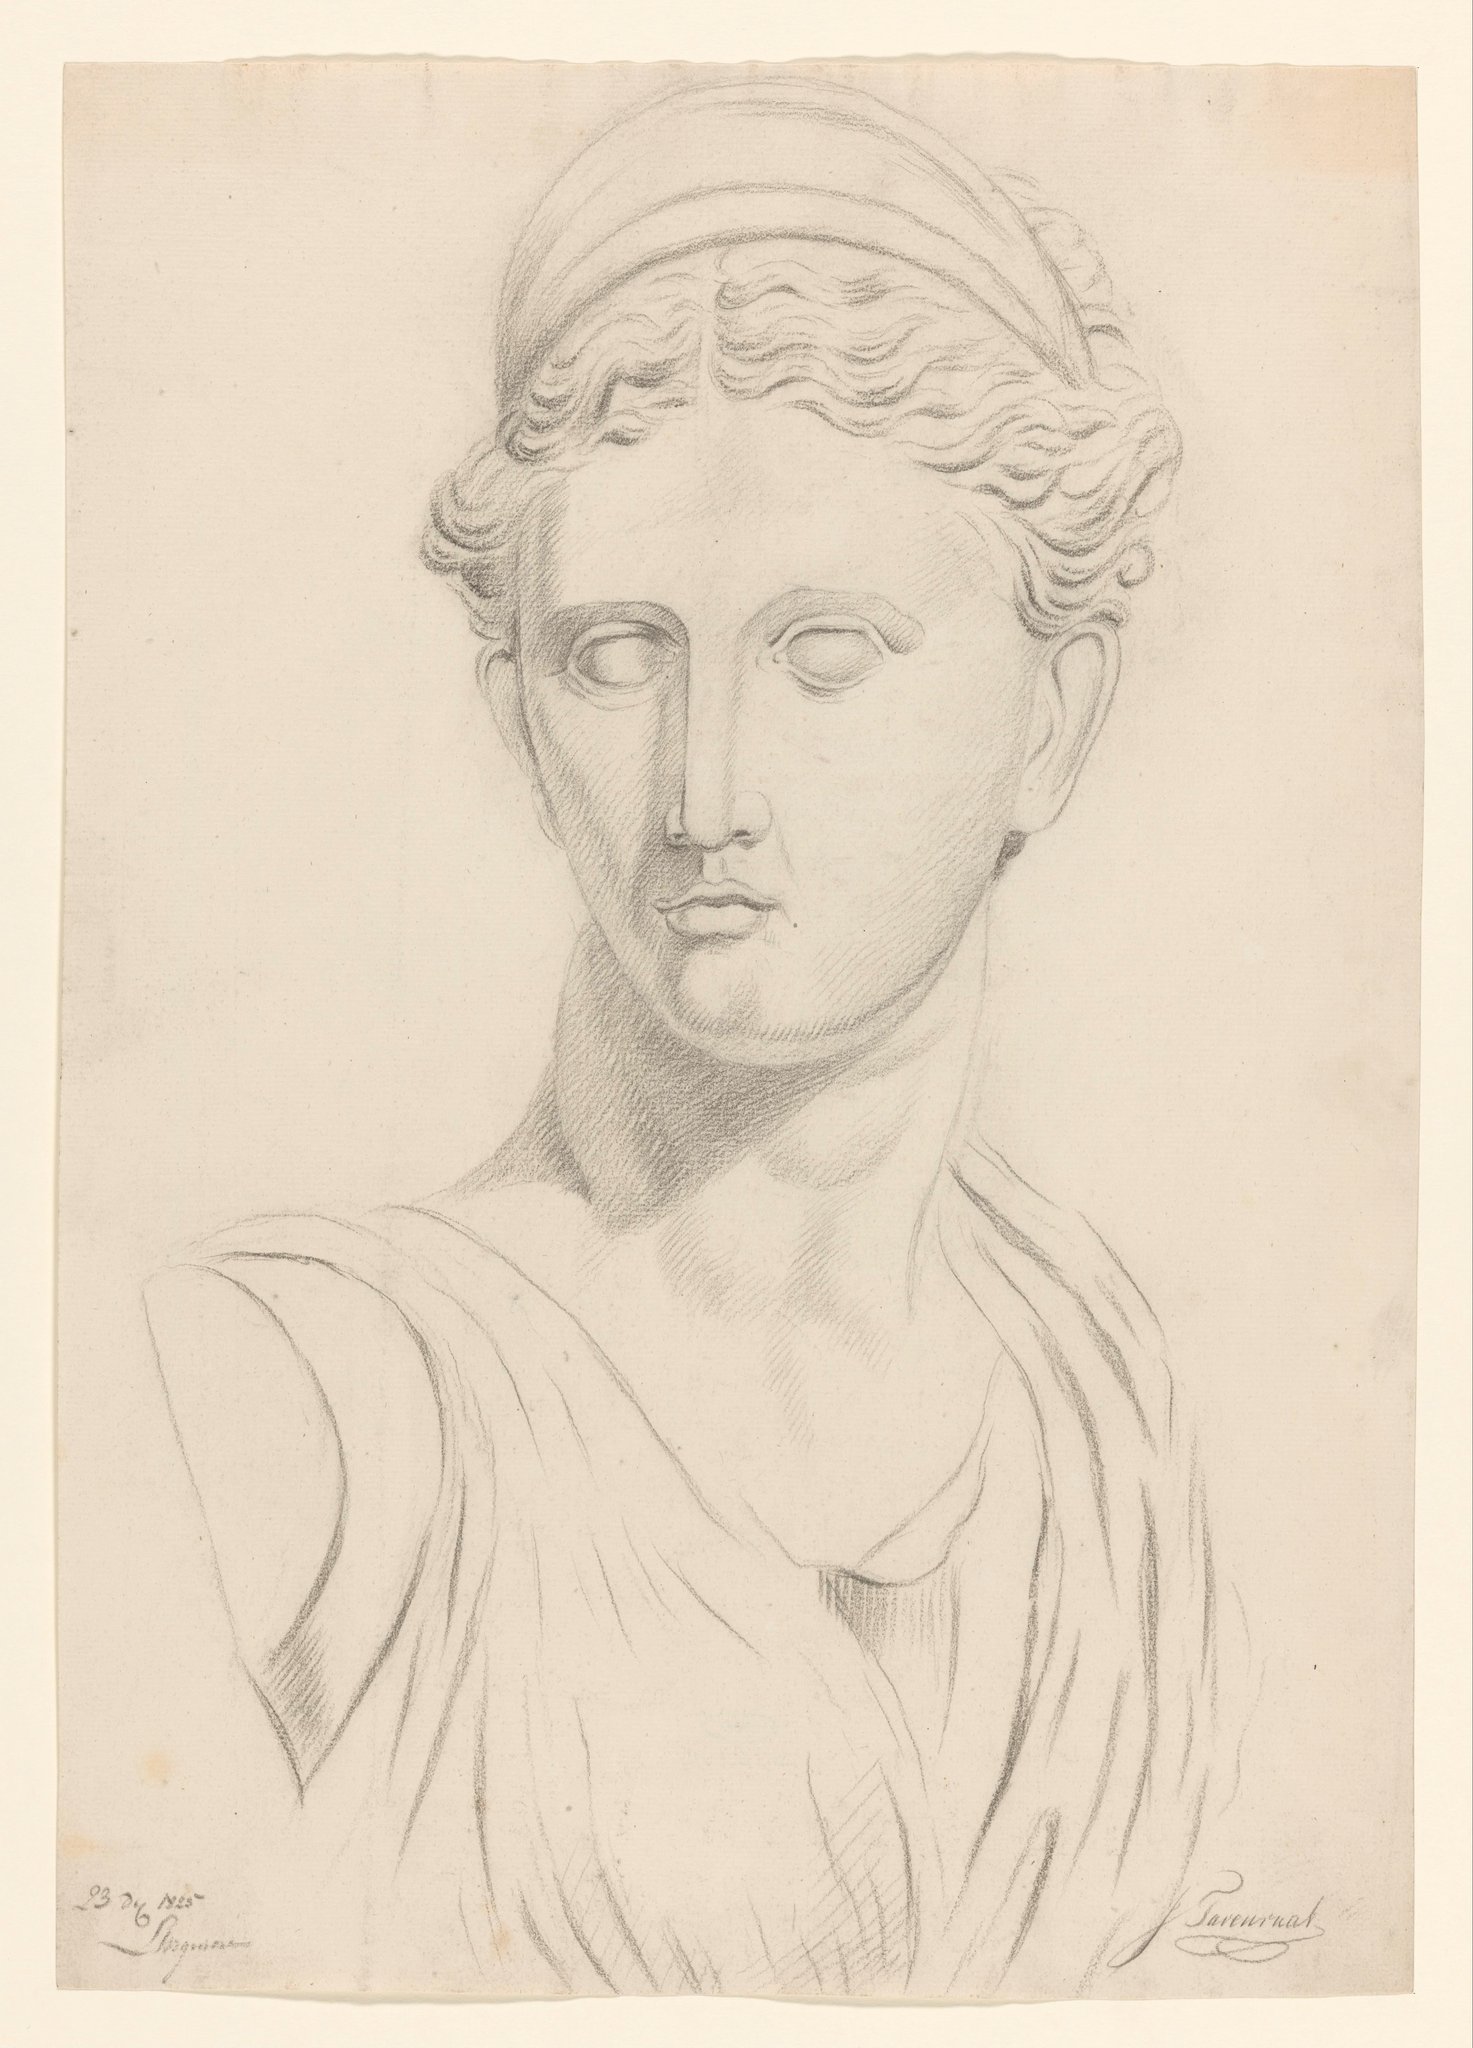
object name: figuurstudie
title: Gips naar antiek beeld van een vrouw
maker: johannes tavenraat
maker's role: draughtsman, painter, print maker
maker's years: 1809-1881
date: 1825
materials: chalk, paper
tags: piece of sculpture, reproduction of a piece of sculpture (+ ceramics ~ arts)